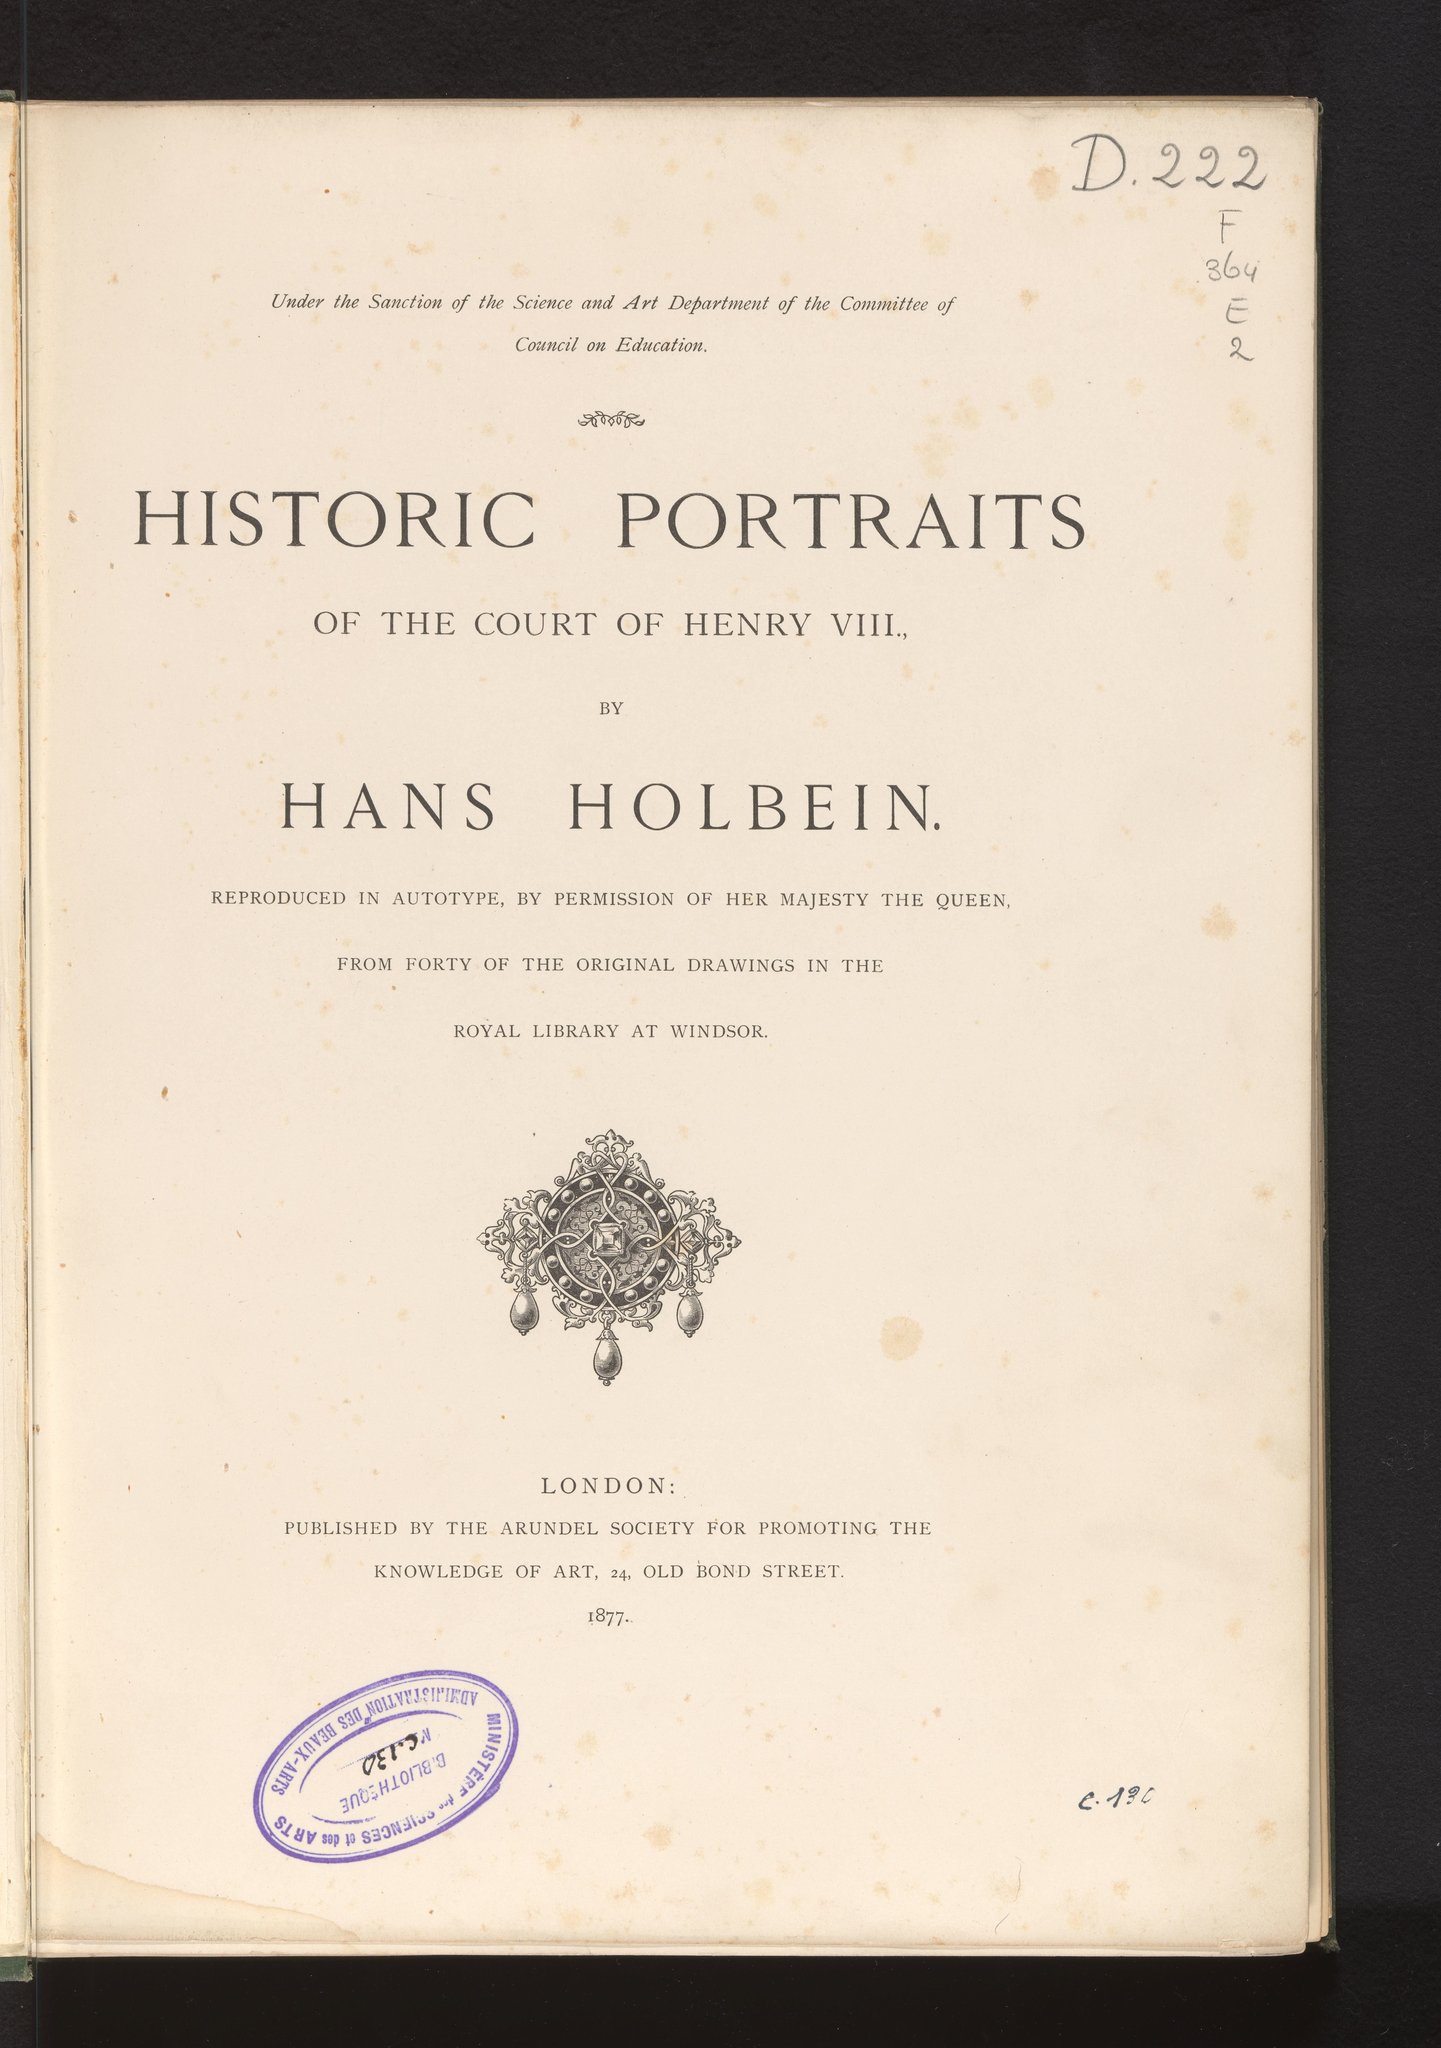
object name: book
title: Historic portraits of the court of Henry VIII., by Hans Holbein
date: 1877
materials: cardboard, leather, linen, photographic support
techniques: carbon print, printing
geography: london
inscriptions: number: ‘1750’, date: ‘SEPT 1997’, collector's mark: ‘Ministère de sciences et des arts/ administration des beaux-arts’, number: ‘C.130’, number: ‘D.222’